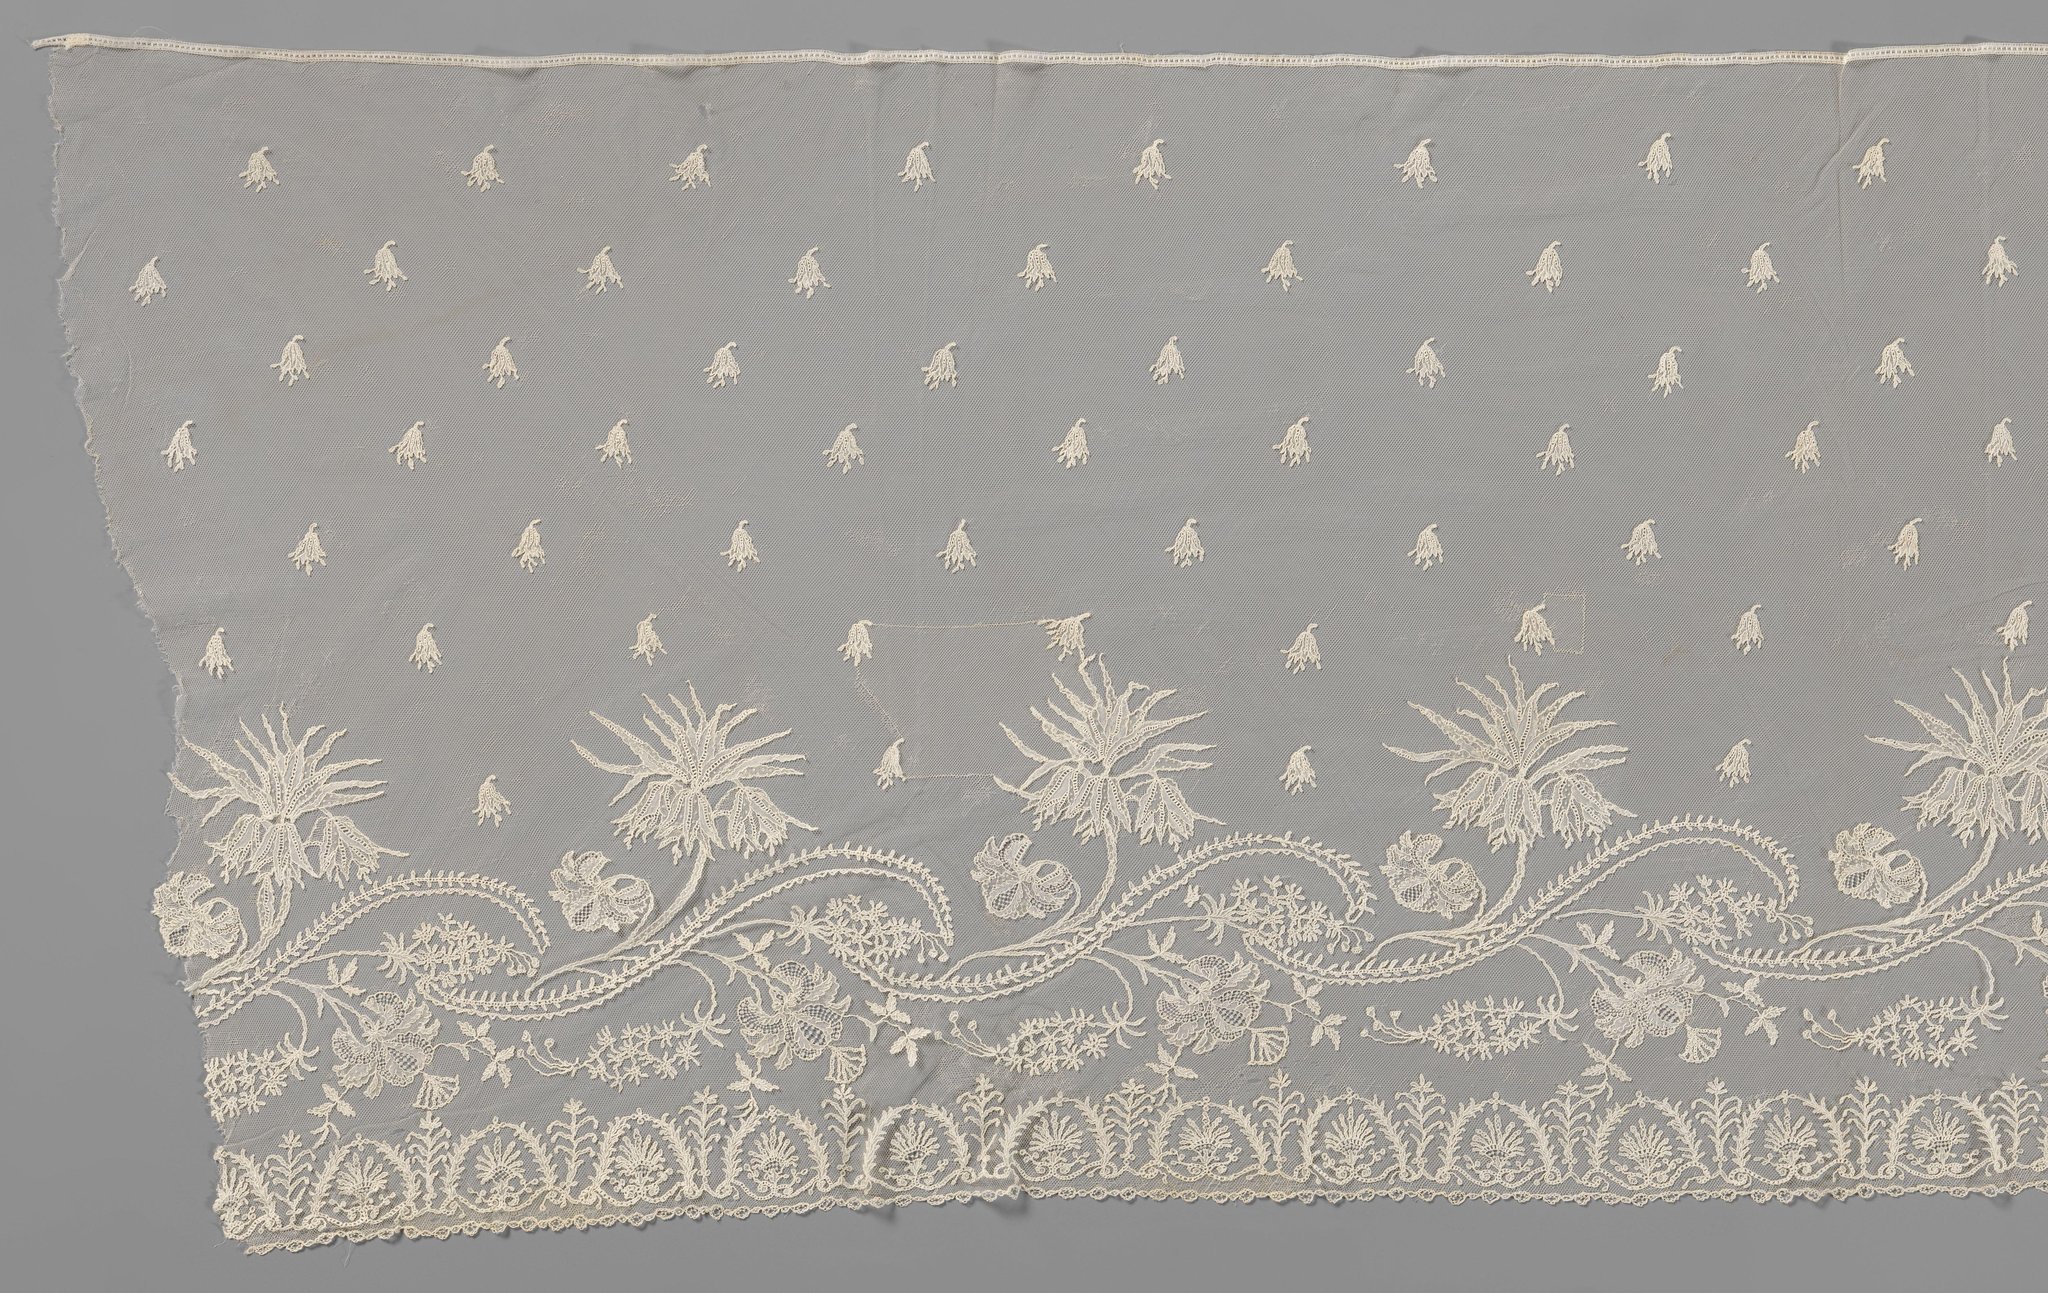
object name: strip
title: Strook applicatiekant met keizerskroon en iris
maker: Anonymous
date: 1800-1809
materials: linen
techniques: lace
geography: brussels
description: Strook naturelkleurige applicatiekant: naaldkant - Brusselse gaaskant - geappliceerd op machinale tule. Aan de onderzijde lopen twee randen. De binnenste en breedste bestaat uit een lopende, vlakke S-rank, die wordt oversneden door een naar rechts gerichte stengel met een opstaande keizerskroon, twee hangende irissen en twee hyacinthen. De buitenste, ornamentale rand bestaat uit palmetjes, onder spitsbogen, afgewisseld met een staand takje. De buitenkant is recht beëindigd door een oogjeslijstje. Een strooipatroon van hangende klokjesbloemen vult de machinale tulegrond boven de randen.